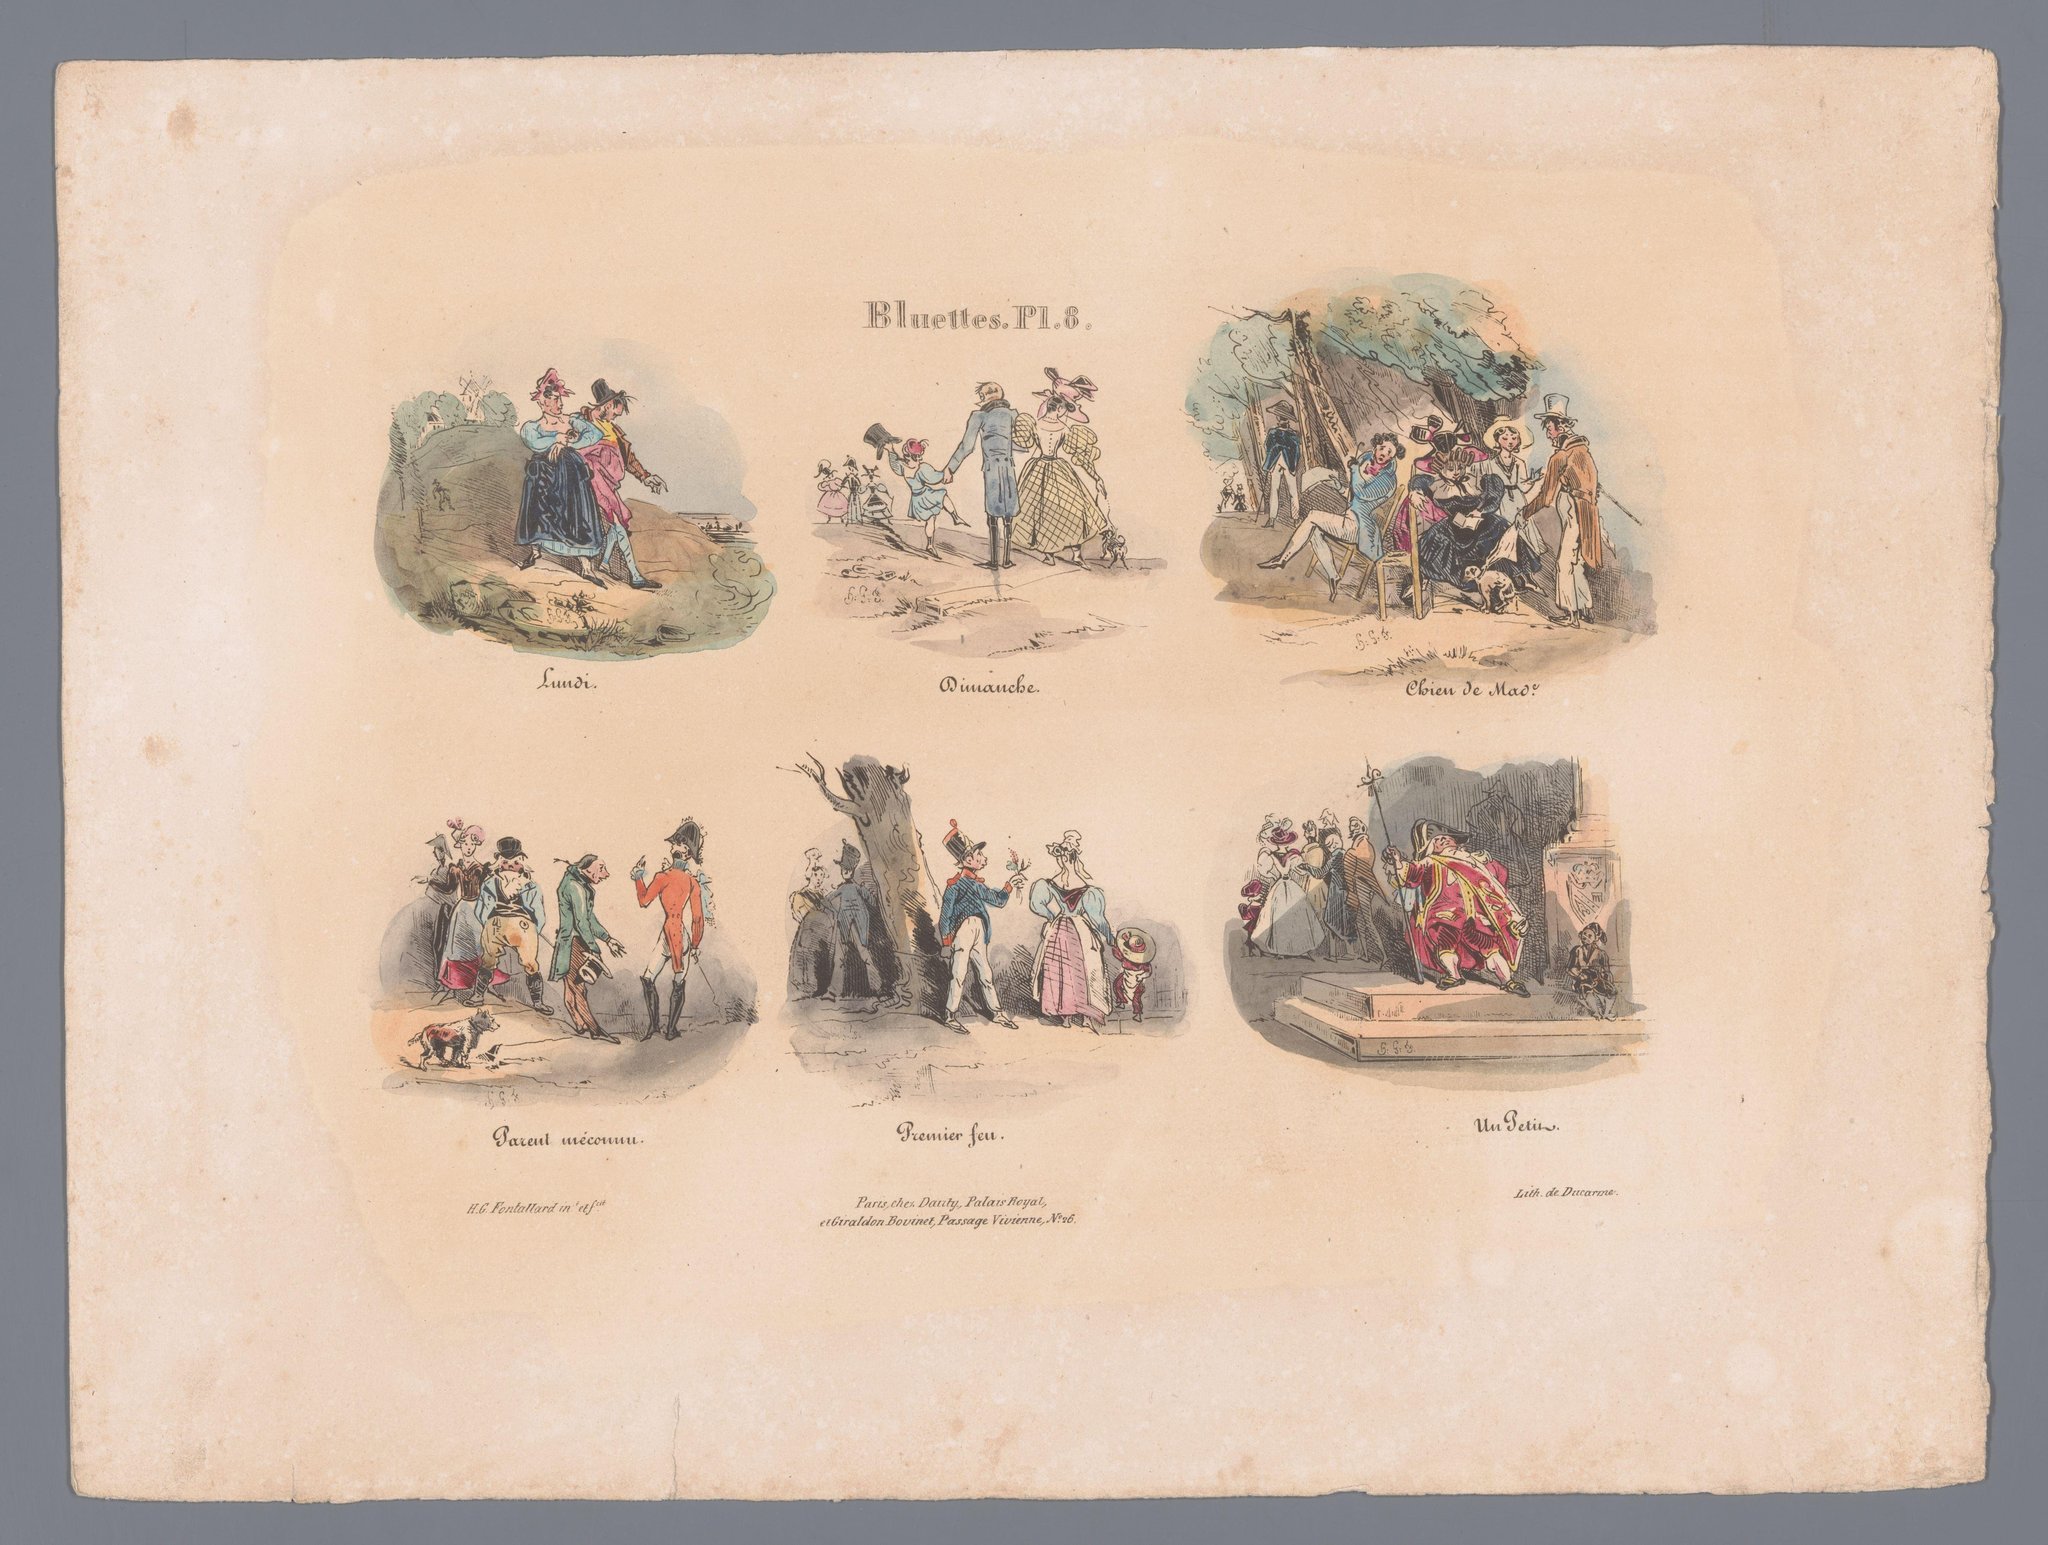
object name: print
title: Zes scènes met diverse personen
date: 1828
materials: paper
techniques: hand coloring, lithograph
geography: paris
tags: various human types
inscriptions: collector's mark: Lugt 2228a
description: Prent maakt deel uit van een omslag met achttien prenten.